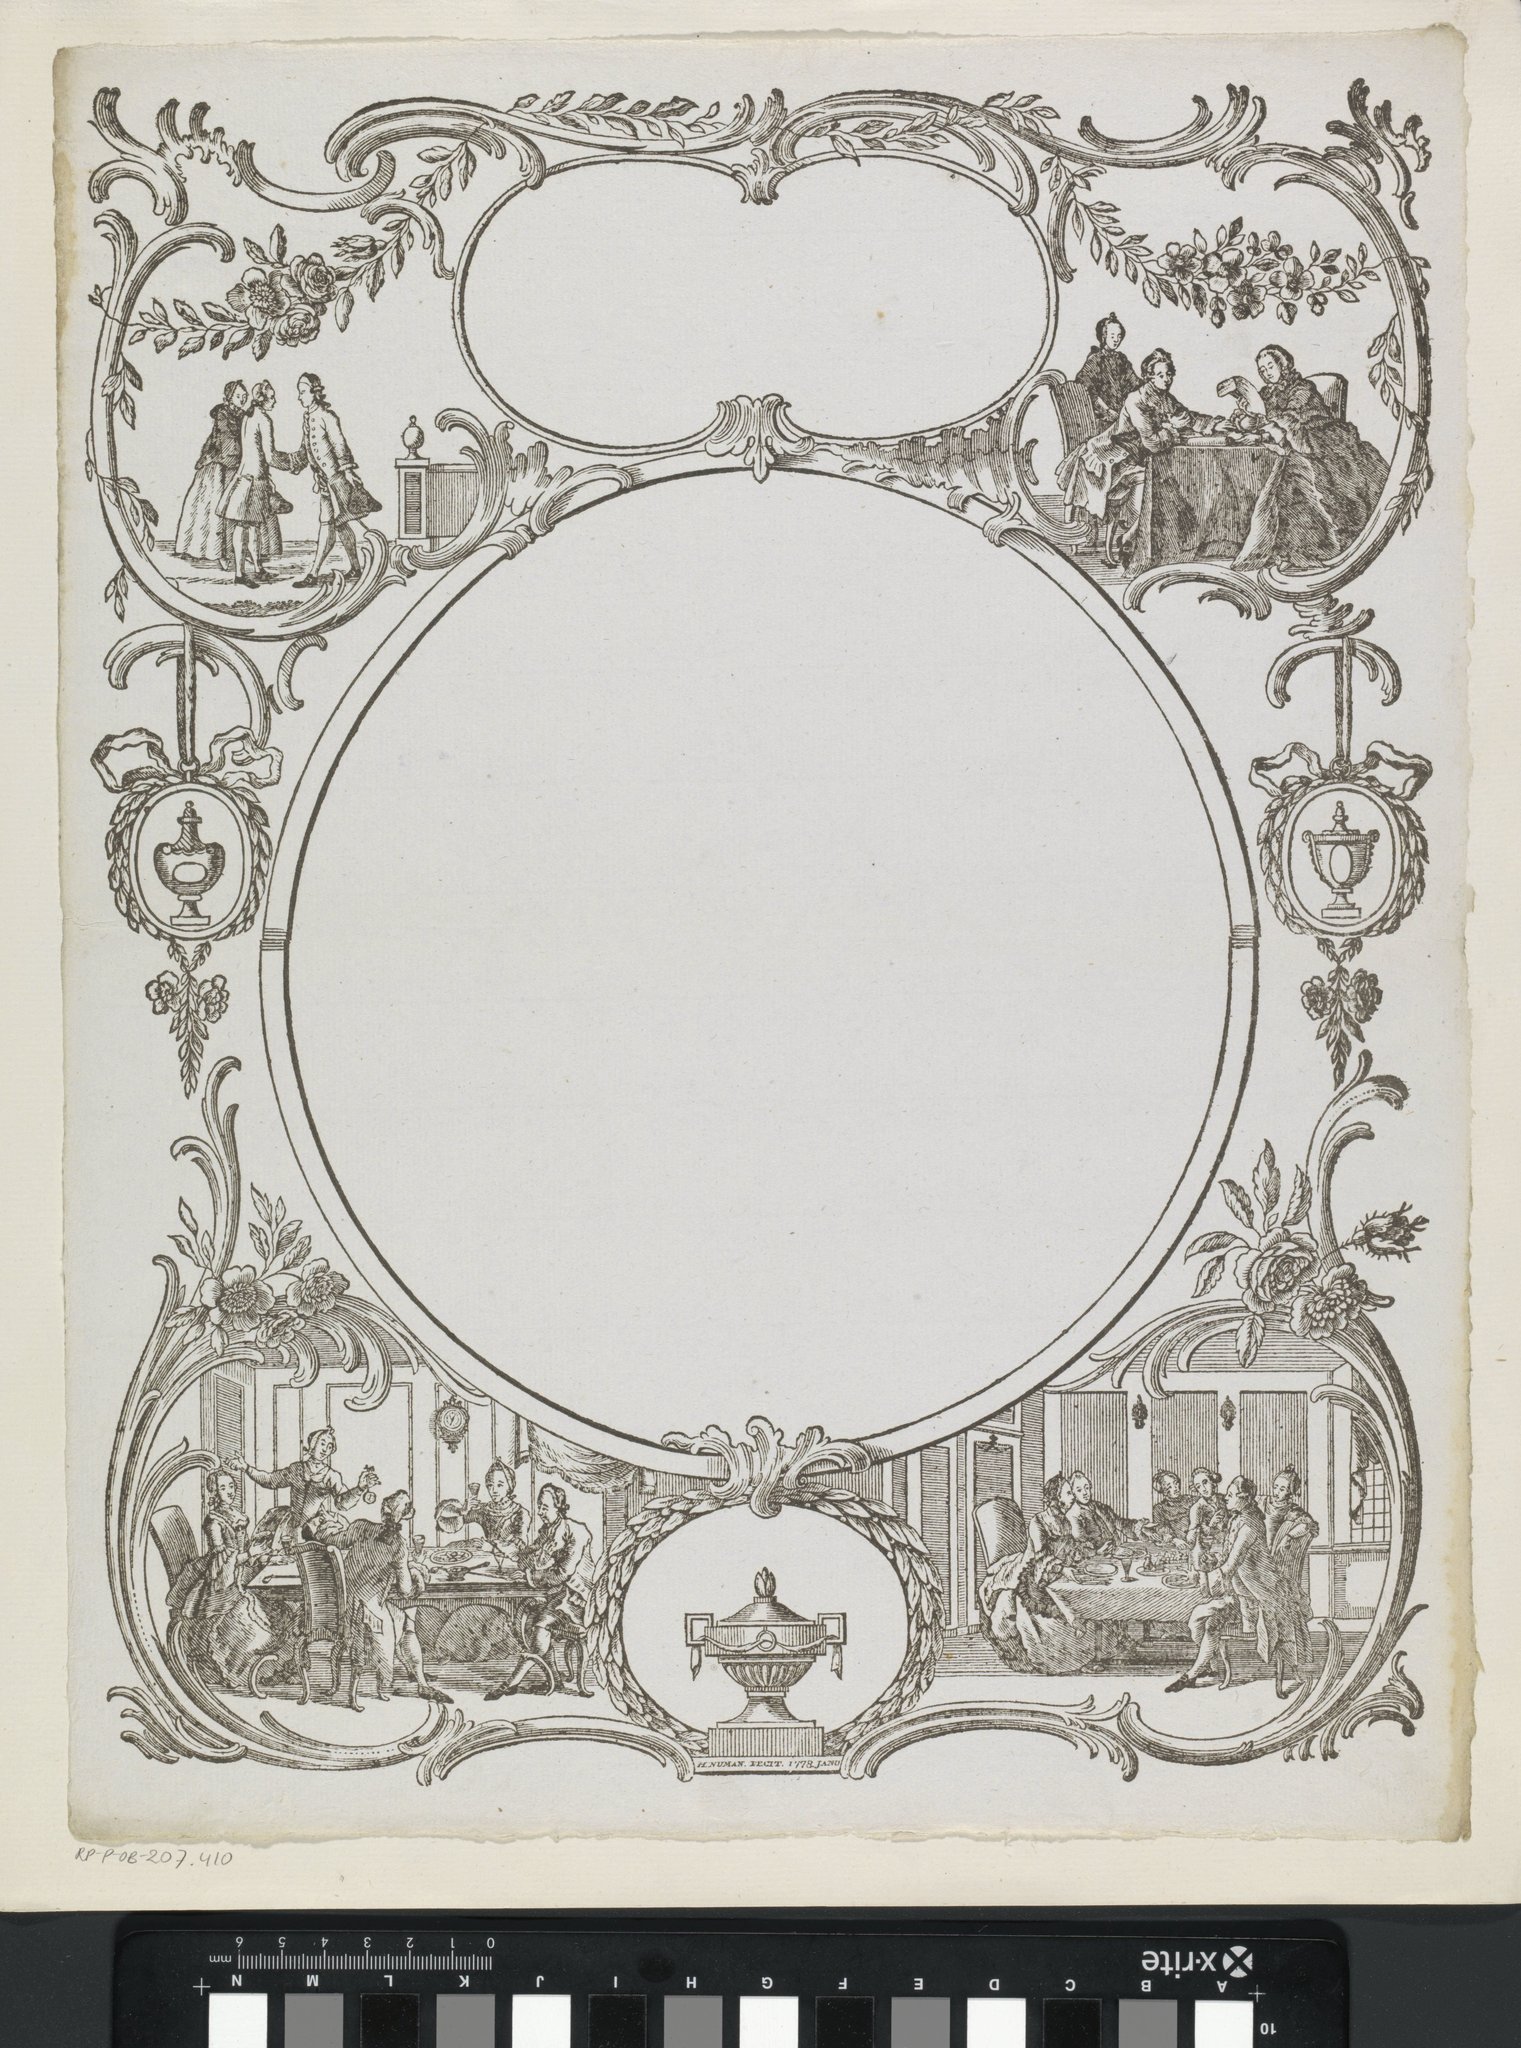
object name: print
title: Wensbrief met decoratief kader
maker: Anonymous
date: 1778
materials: paper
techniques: woodcut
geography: netherlands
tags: shaking hands, 'dextrarum junctio', evening meal, dinner, supper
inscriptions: collector's mark: Lugt 2760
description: Wensbrief met onbeschreven cartouche binnen een decoratief kader met voorstellingen van gezelschapen rond een tafel, en twee mannen die elkaar de hand schudden.